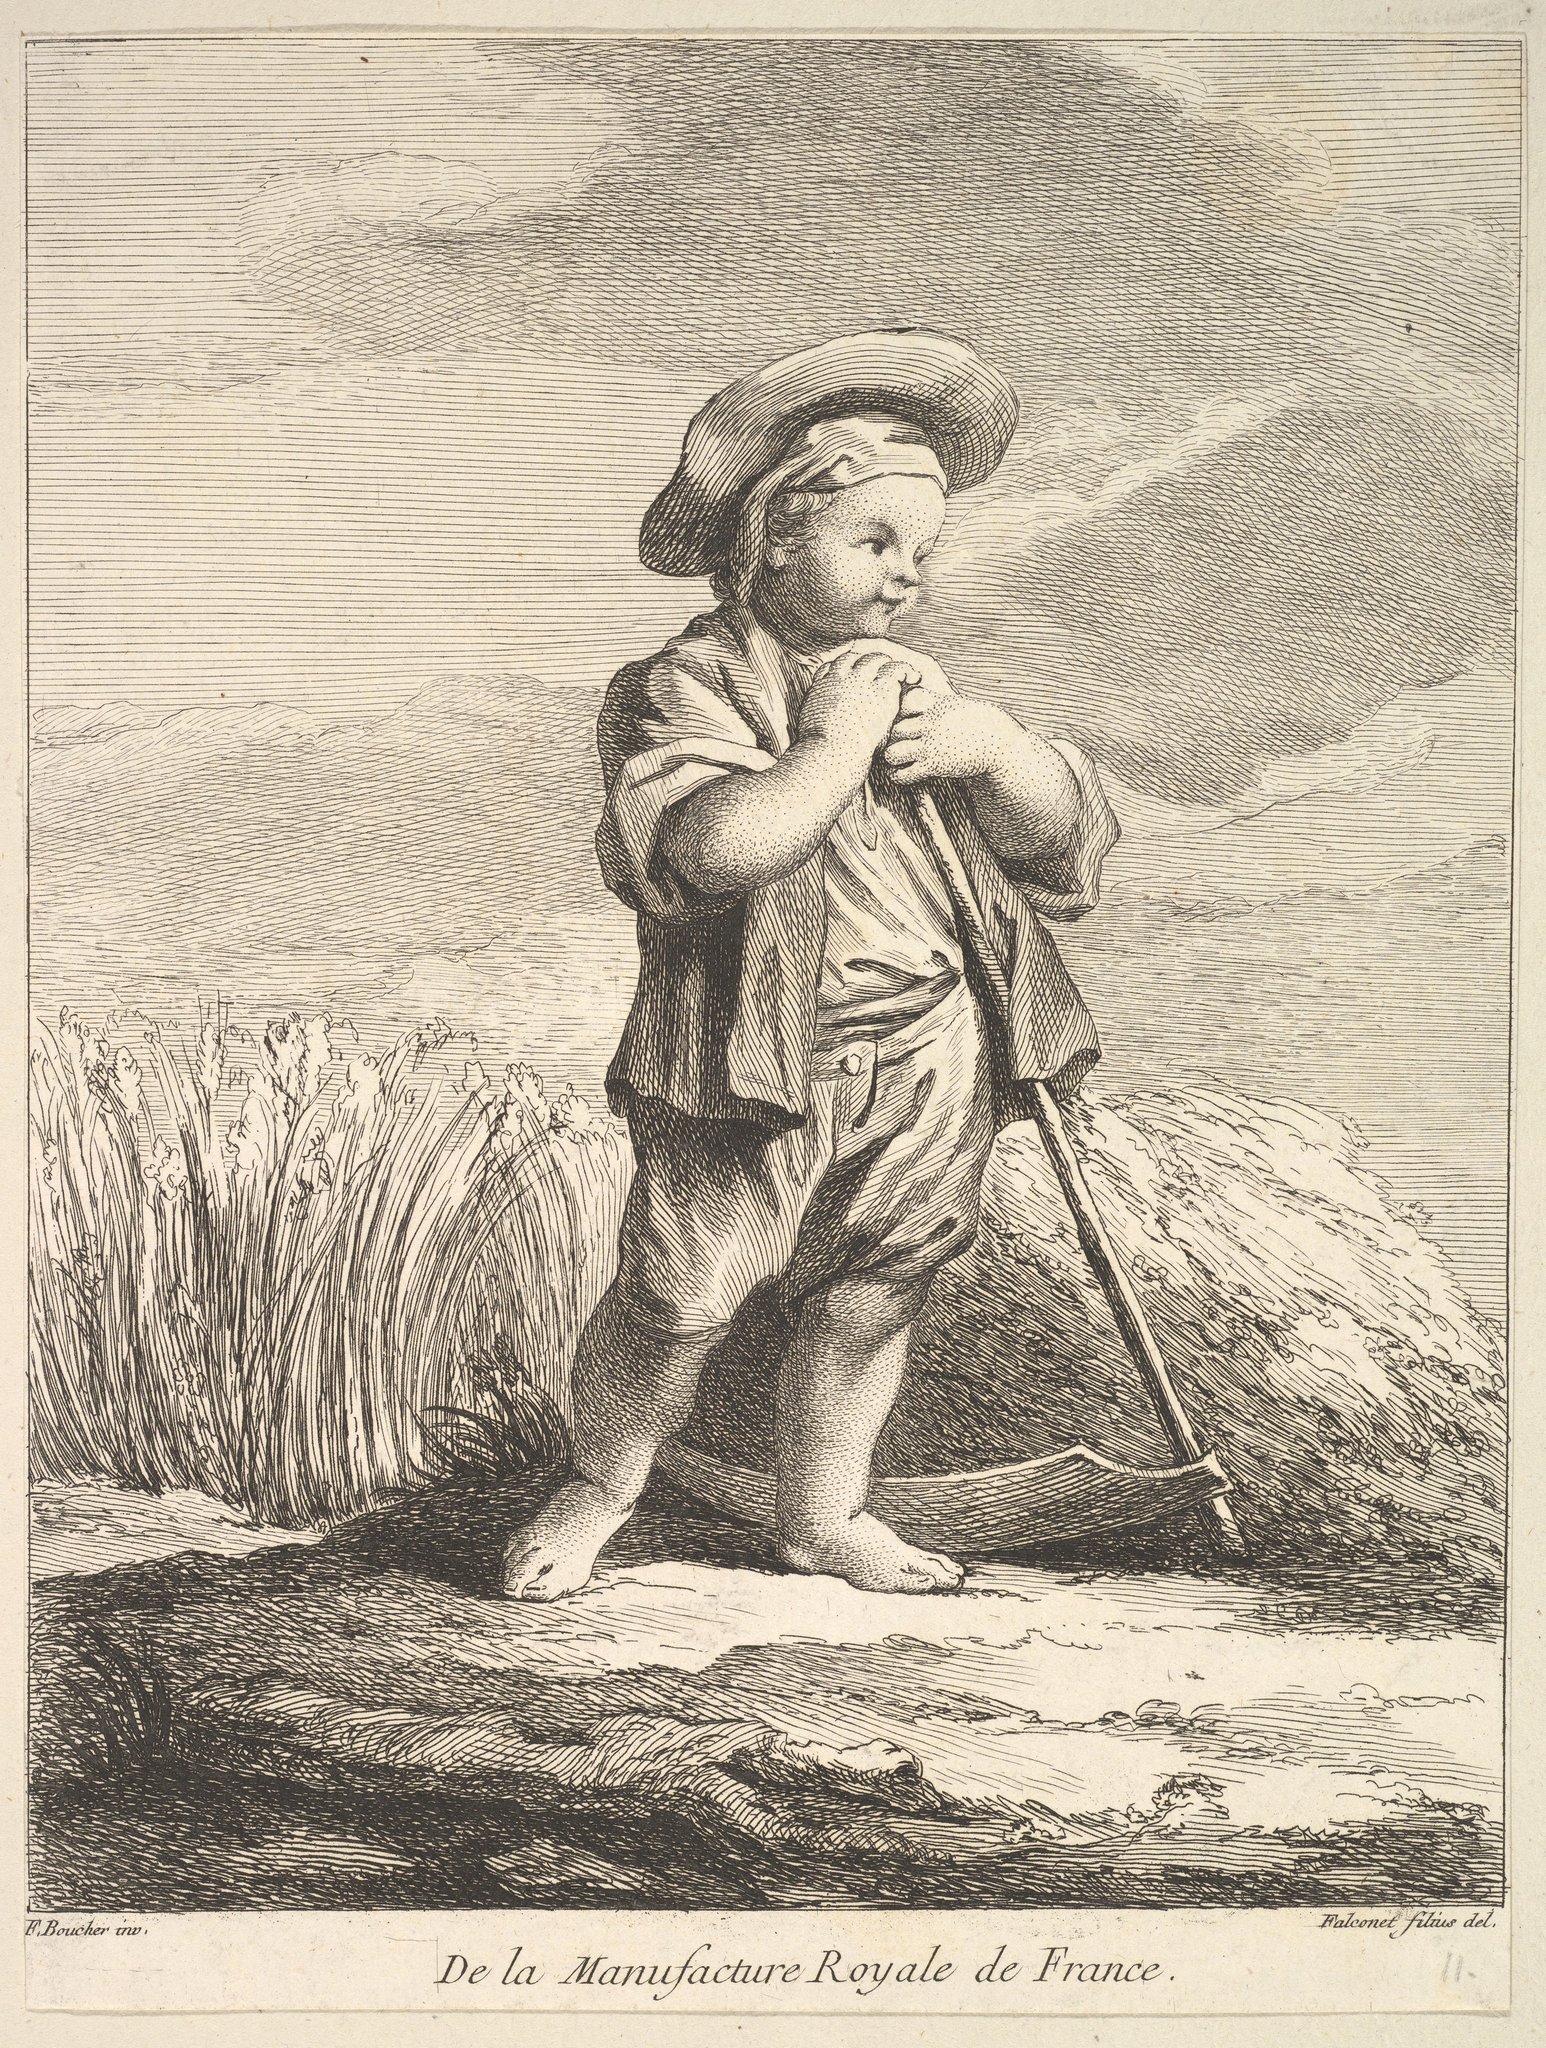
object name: collection ornament architecture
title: Little boy with a scythe, from Premier Livre de Figures d'après les porcelaines de la Manufacture Royale de France, inventées en 1757, par Mr. Boucher (First Book of Figures after porcelains from the Manufacture Royale de France, devised in 1757, by Mr. Boucher)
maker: pierre etienne falconet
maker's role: artist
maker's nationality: french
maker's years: 1741-1791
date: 1757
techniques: engraving, etching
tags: boys